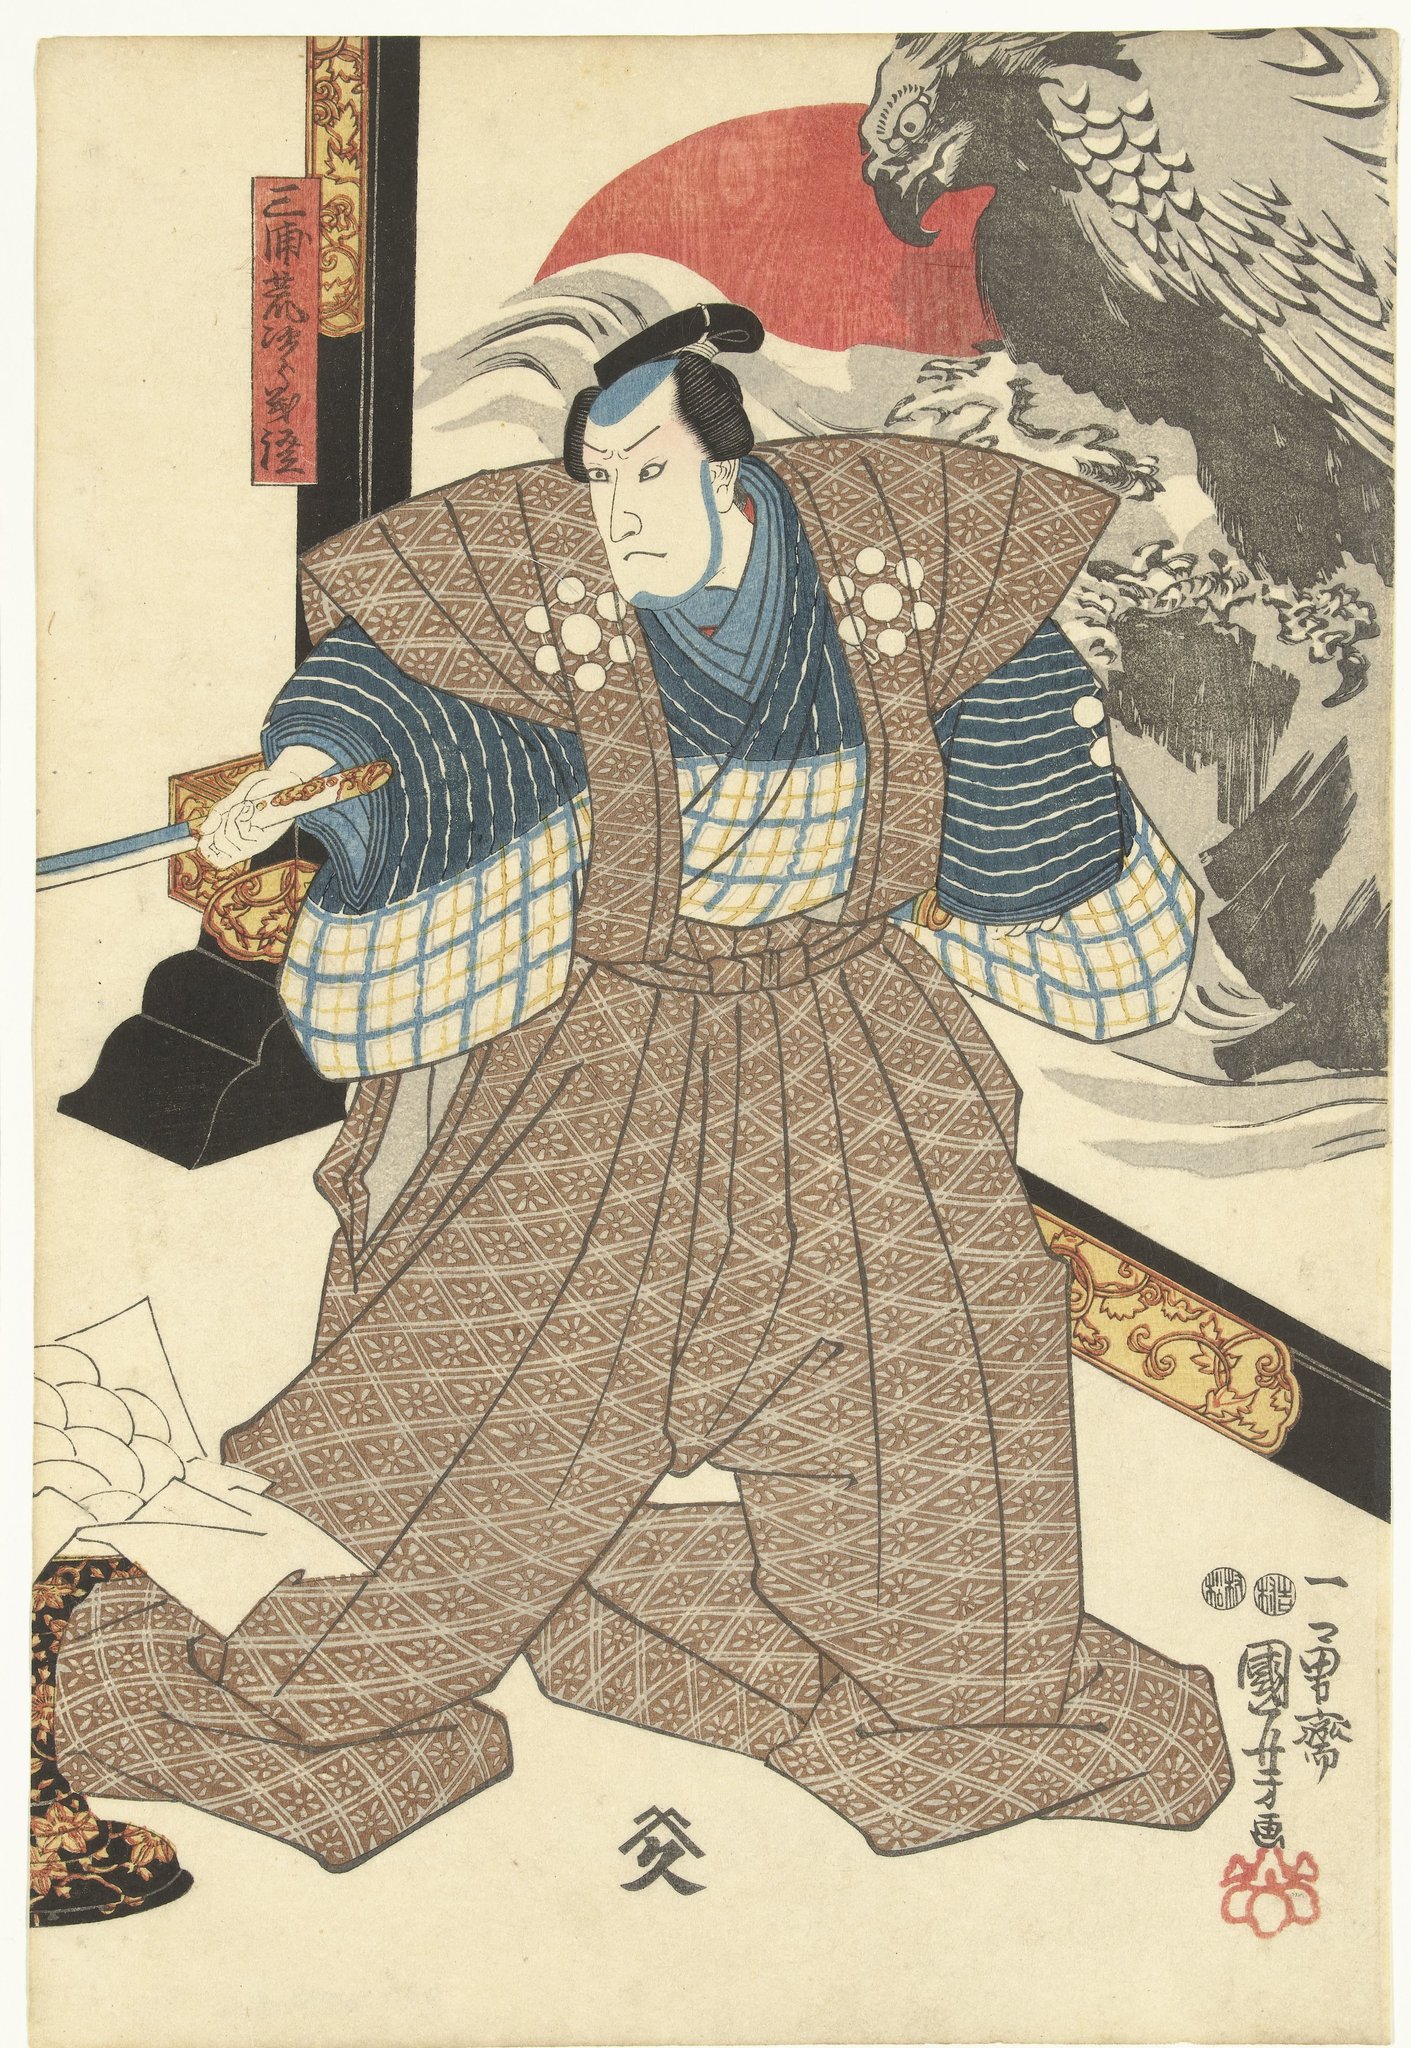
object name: print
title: Drie acteurs bij een kamerscherm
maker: utagawa kuniyoshi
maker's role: draughtsman, print maker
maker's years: 1798-1861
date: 1847-1848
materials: paper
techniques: woodcut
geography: tokyo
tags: actor (on the stage), screen, folding screen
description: Acteur met zwaard in rechter hand, staand bij kamerscherm waarop afbeelding van arend op rots in zee met rode zon.